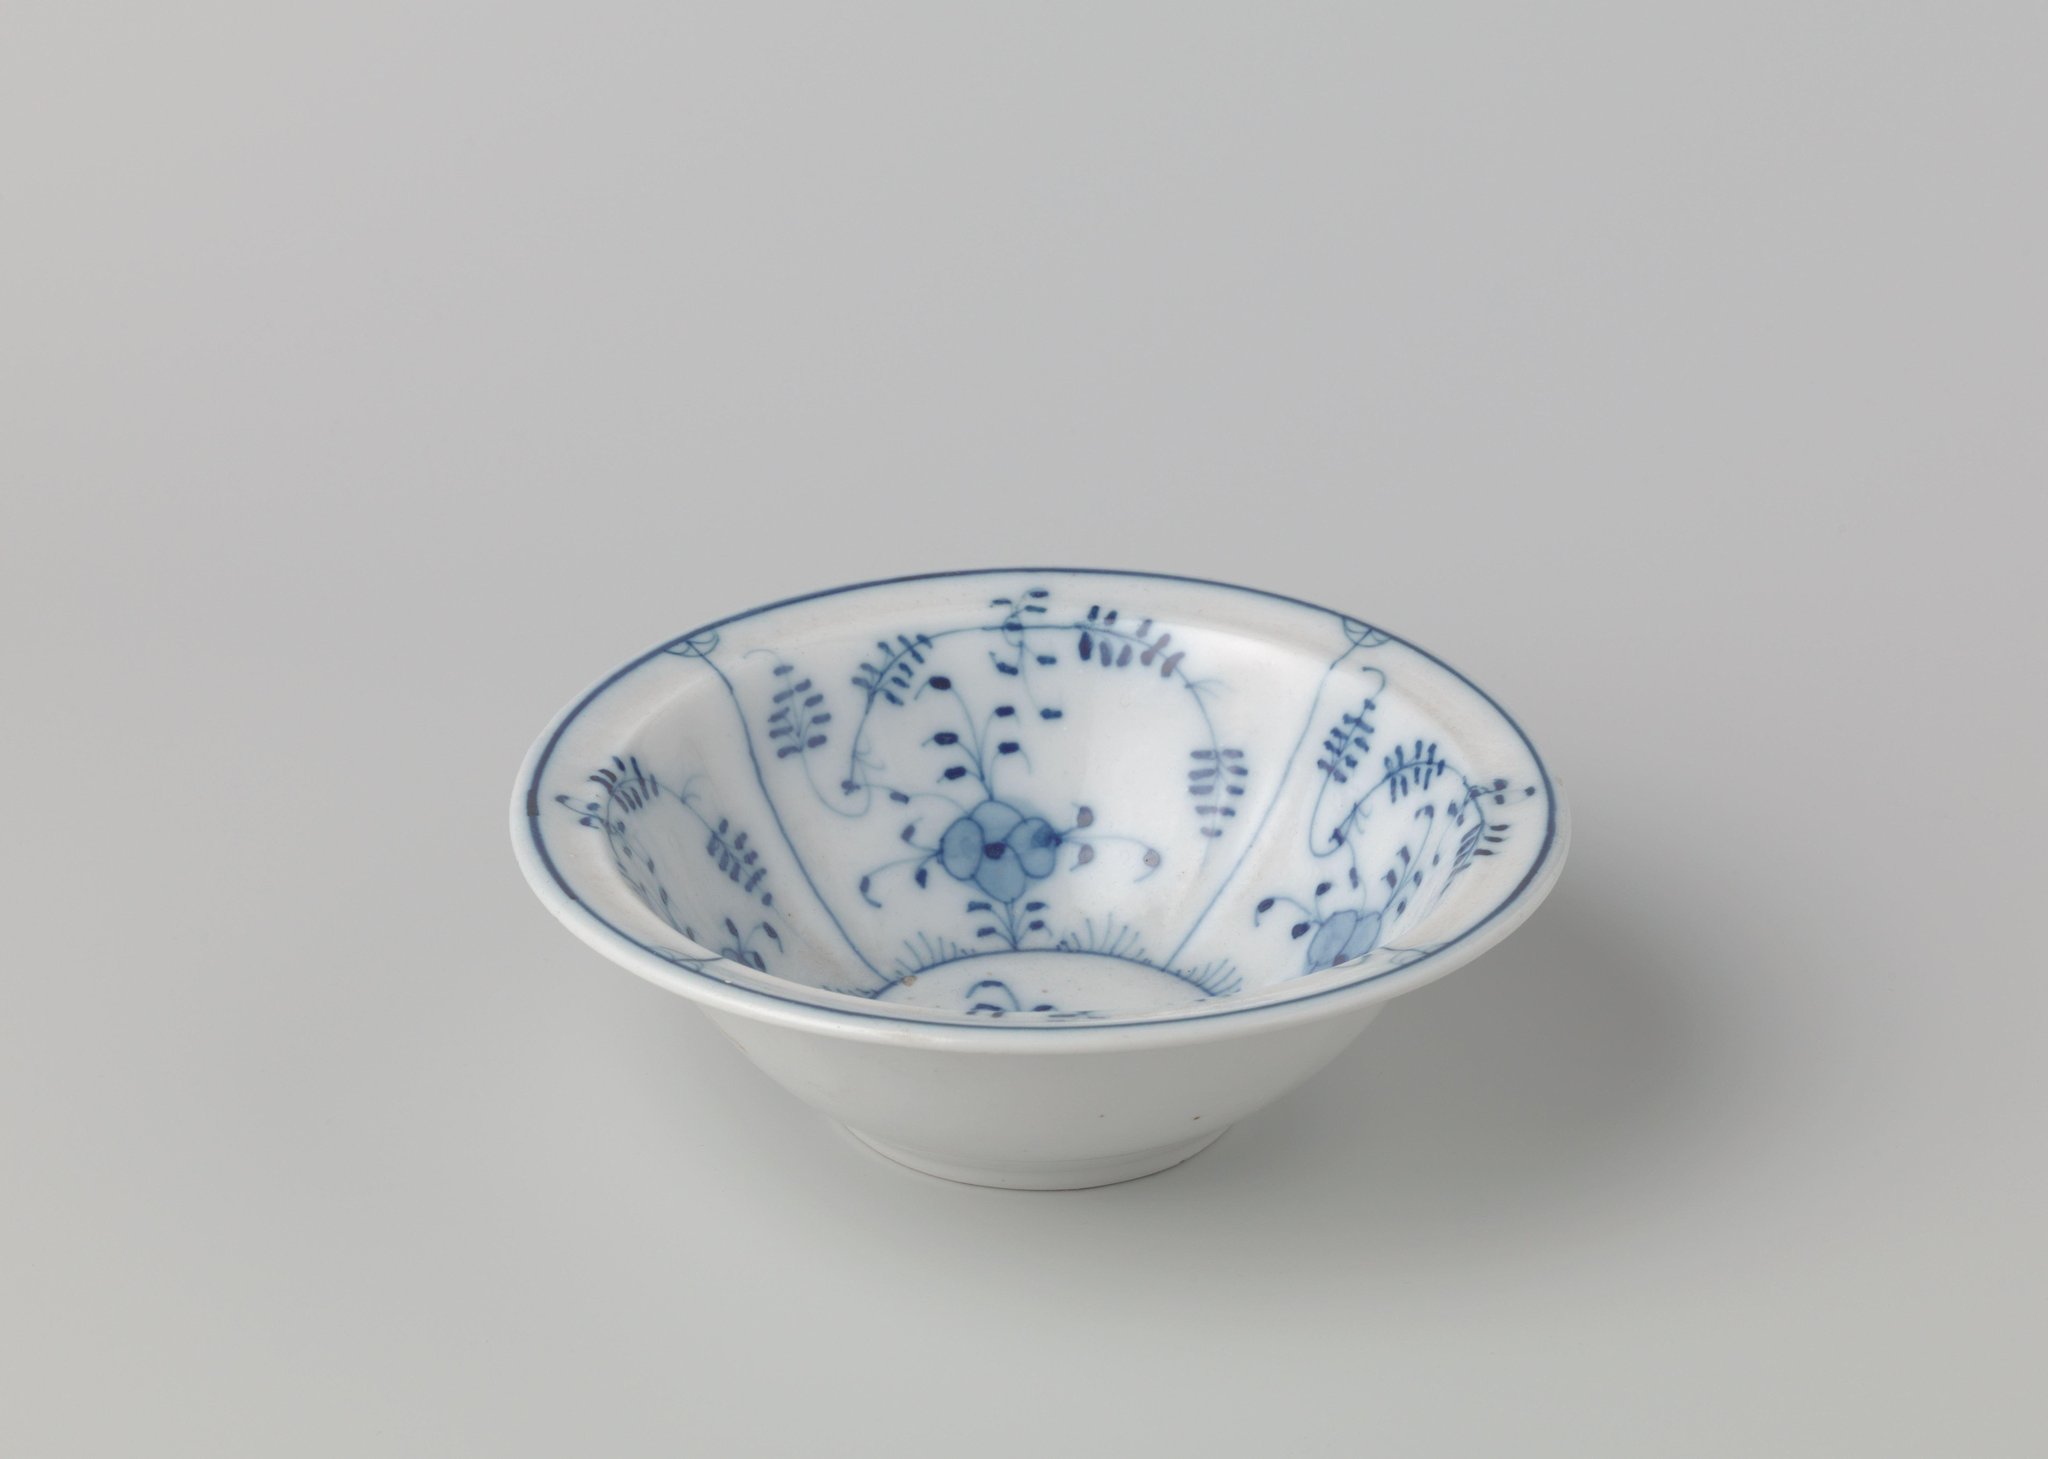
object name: wastafelservies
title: Waskom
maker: Anonymous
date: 1775-1800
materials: ceramic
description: Waskom met blauw Saksisch patroon, ongemerkt.